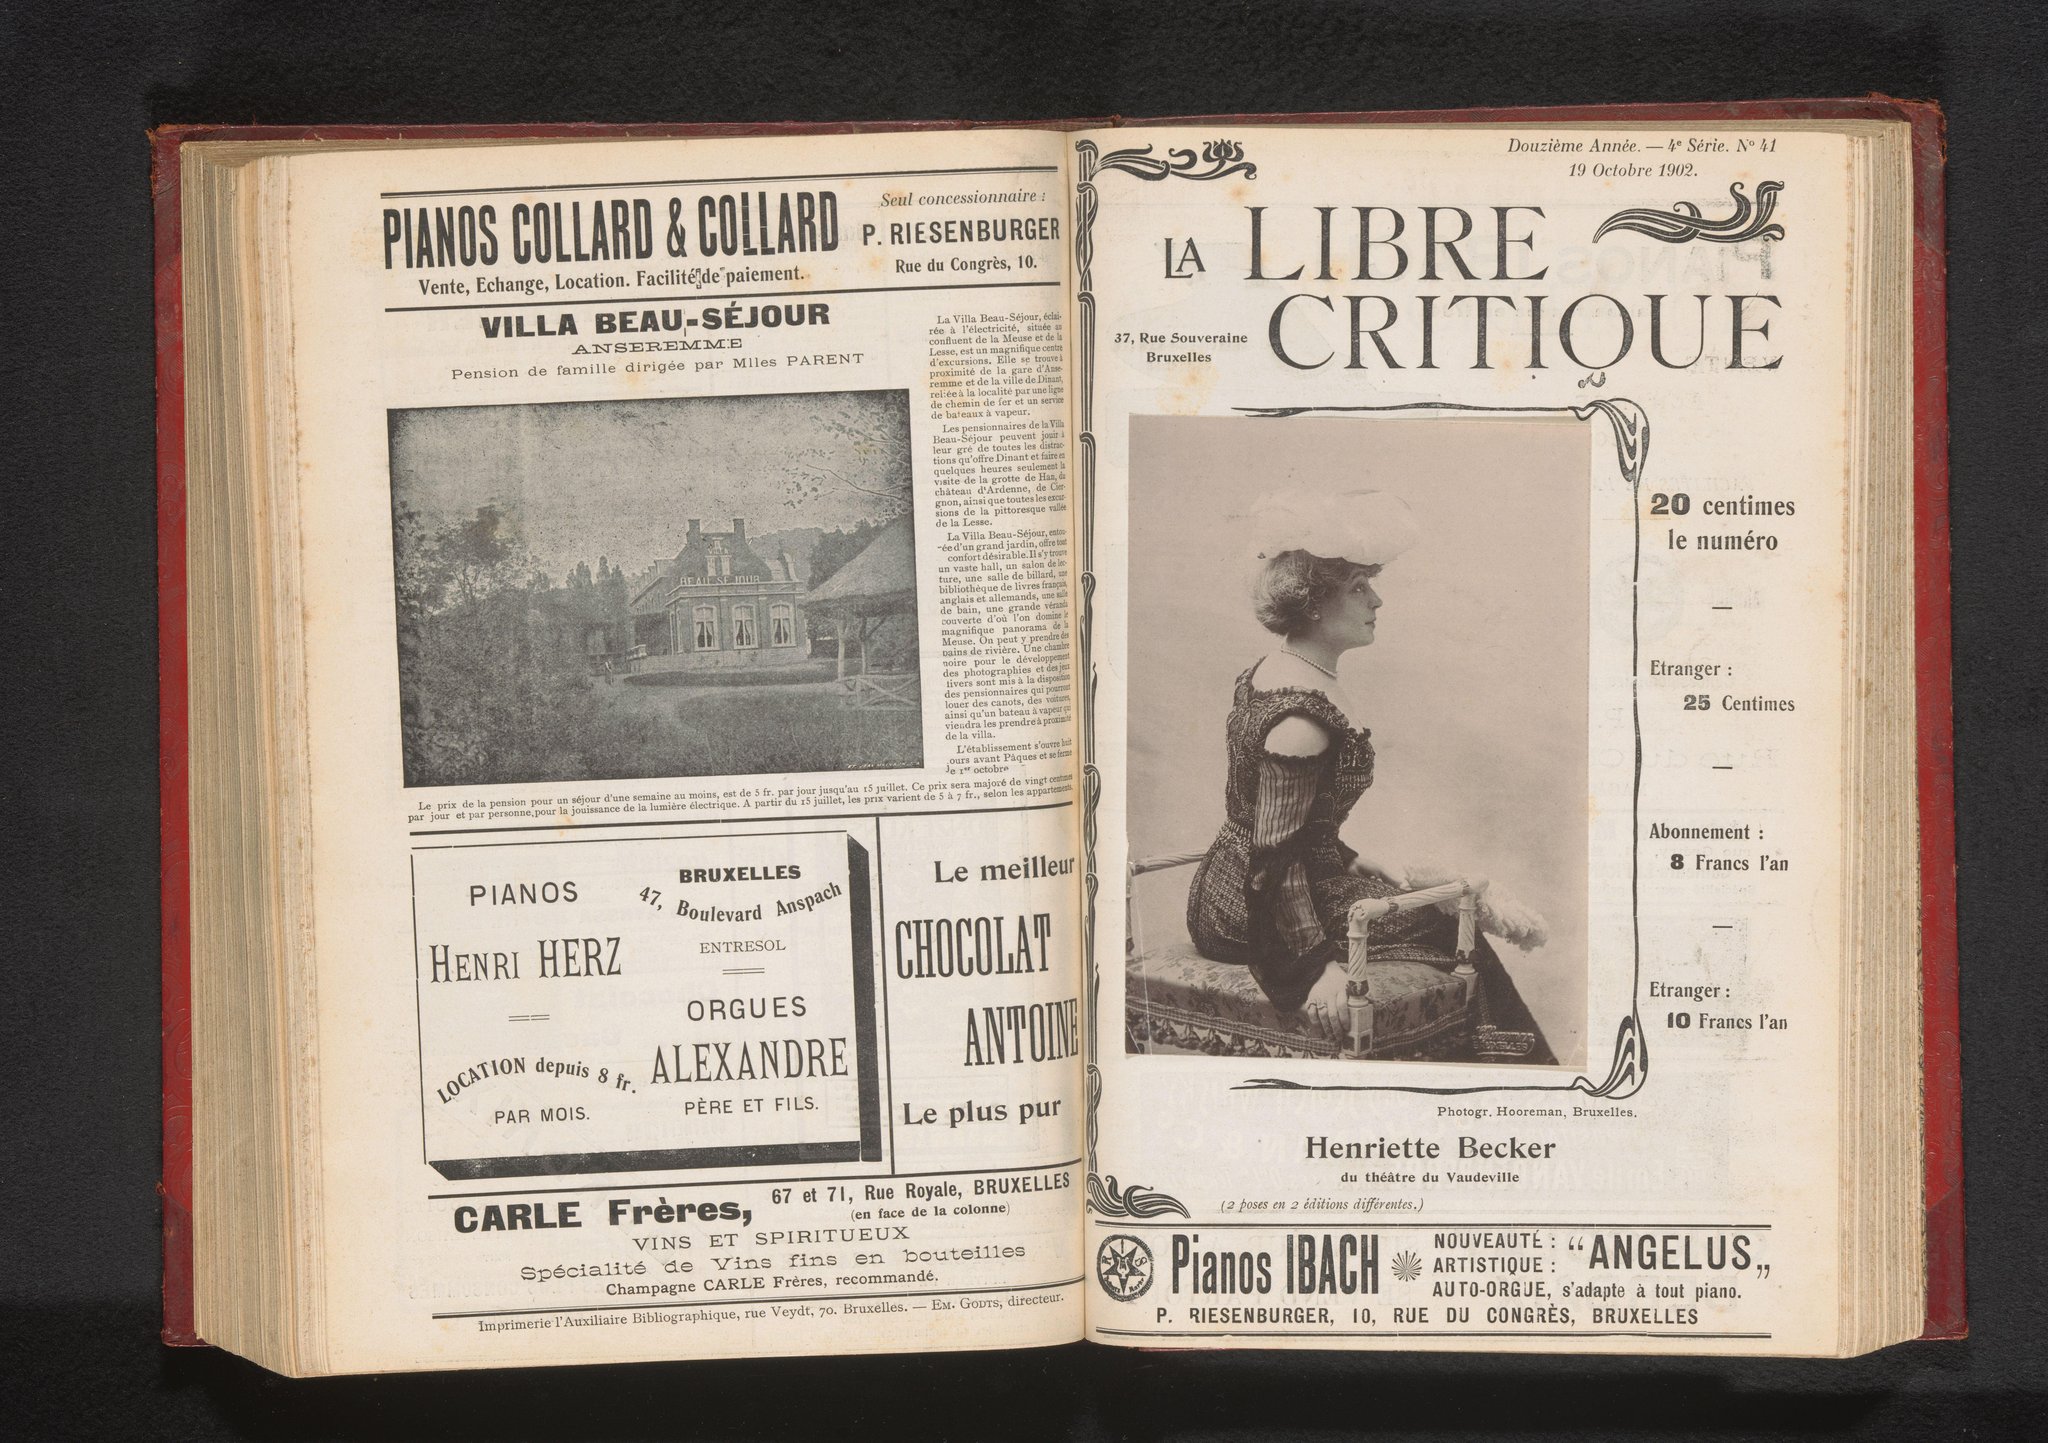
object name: photomechanical print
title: Portret van Henriette Becker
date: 1897-1902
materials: paper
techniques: photograph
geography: brussels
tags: portrait of actor, actress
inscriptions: inscription: ‘du théâtre du Vaudeville’